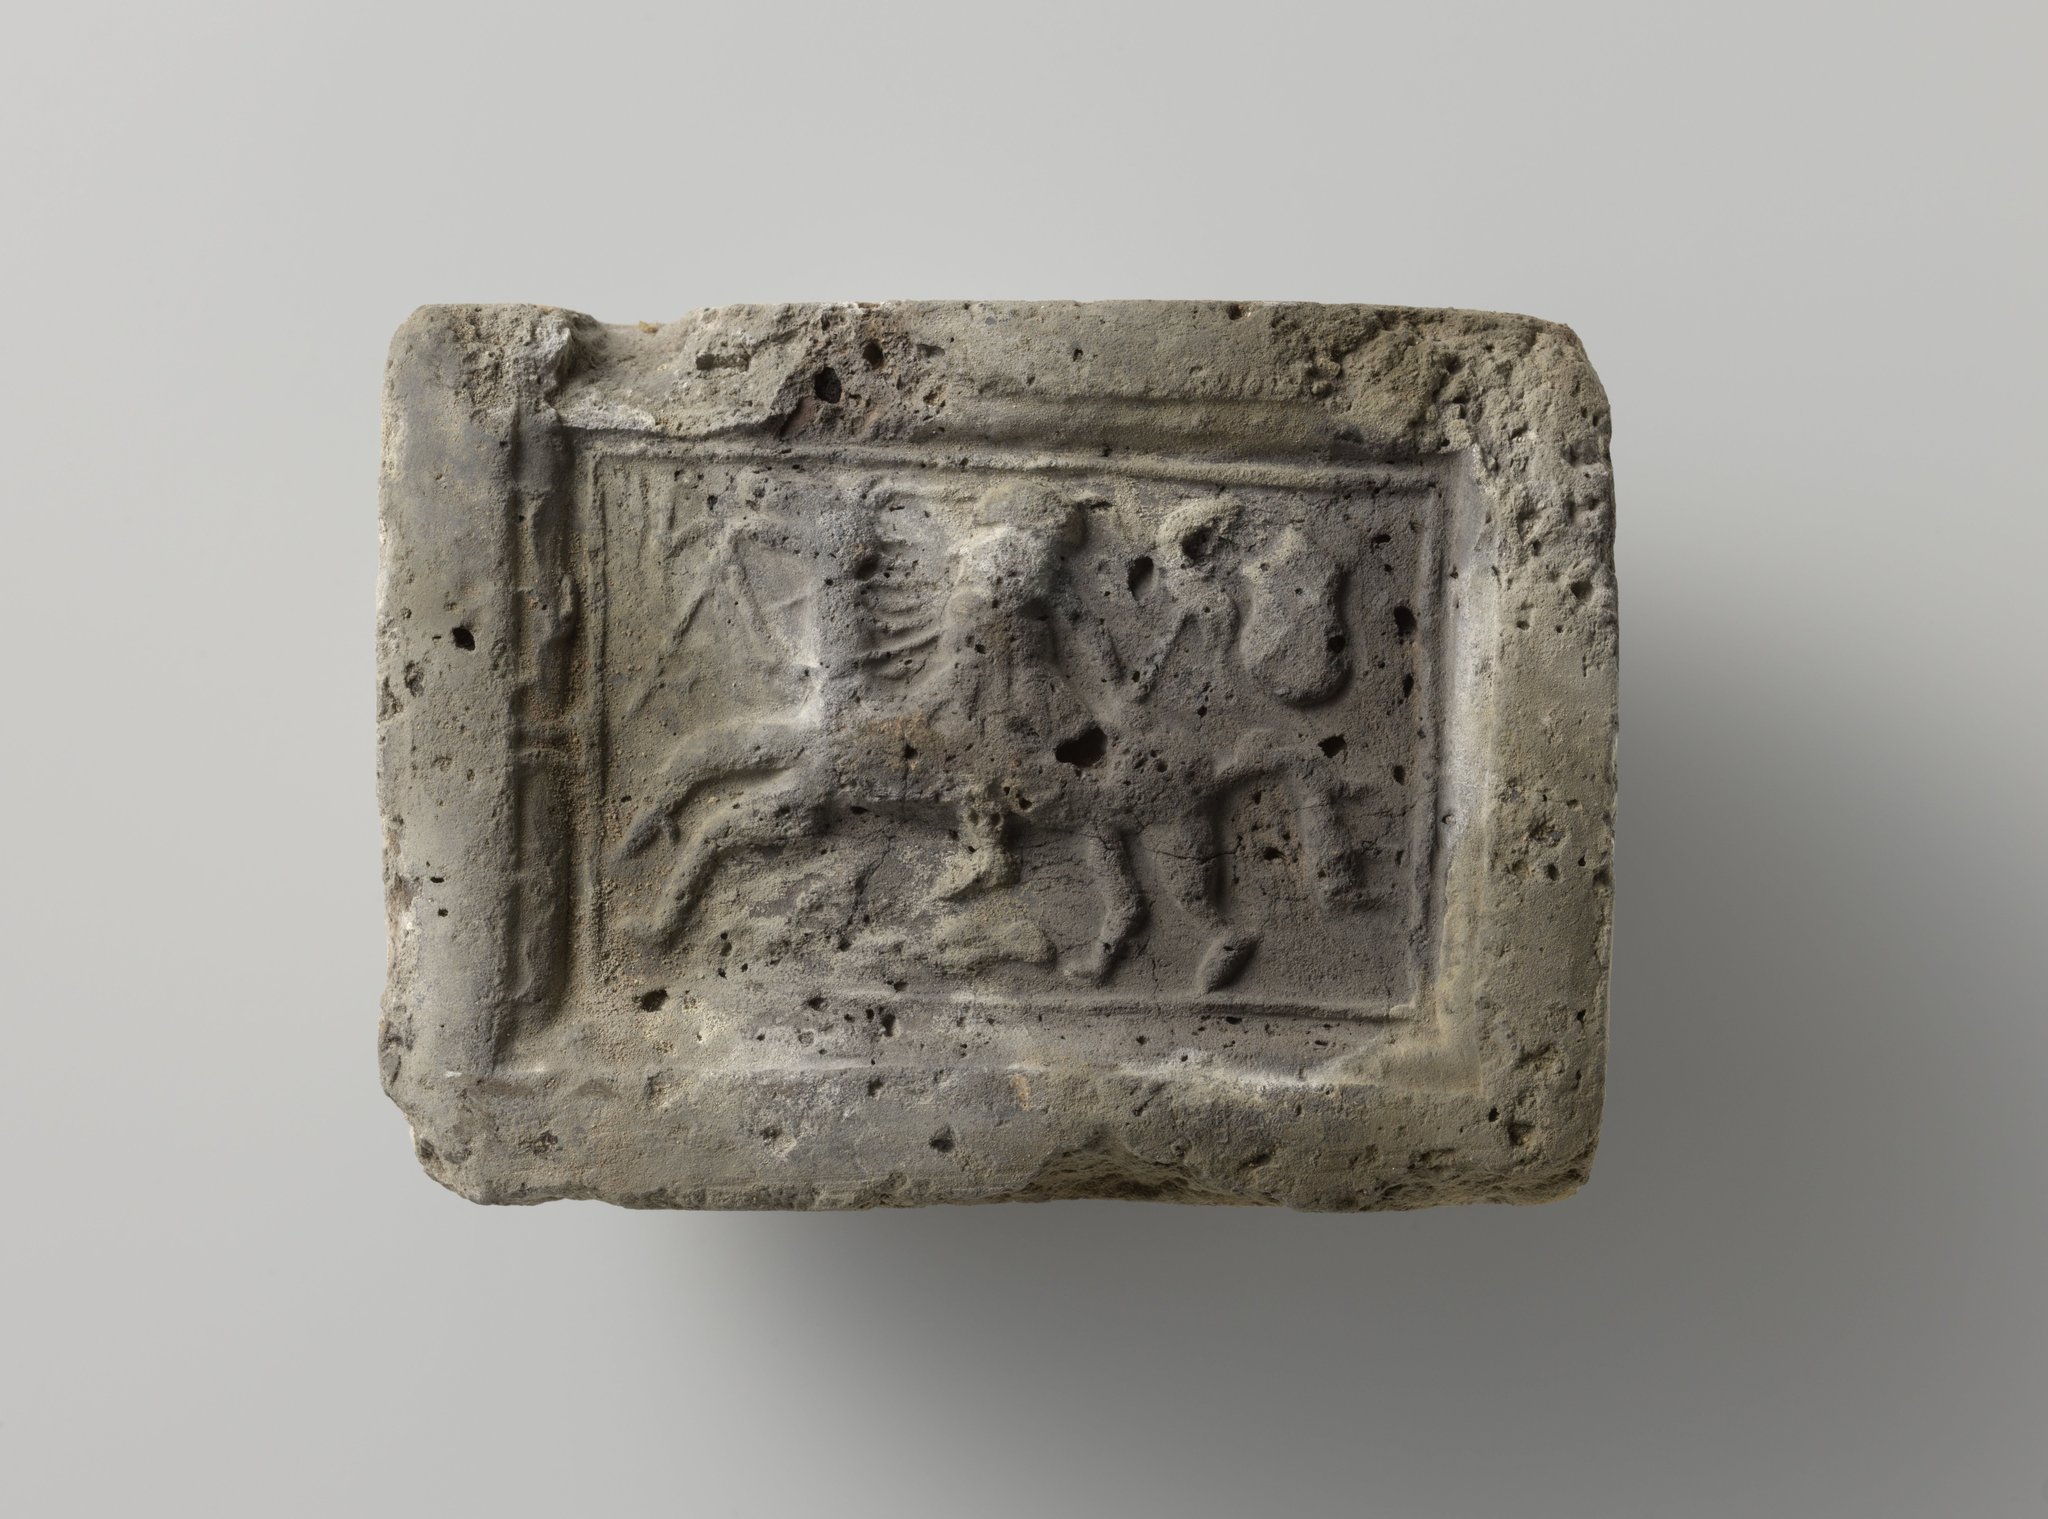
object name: hearthstone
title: Gebakken haardsteen, met in een vierkante lijst een grotesk paard en ruiter, en met een wapenschild en St. Andrieskruis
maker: Anonymous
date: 1525-1575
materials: earthenware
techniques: firing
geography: southern netherlands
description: Gebakken haardsteen, met in een vierkante lijst een grotesk paard en ruiter, en met een wapenschild en St. Andrieskruis.